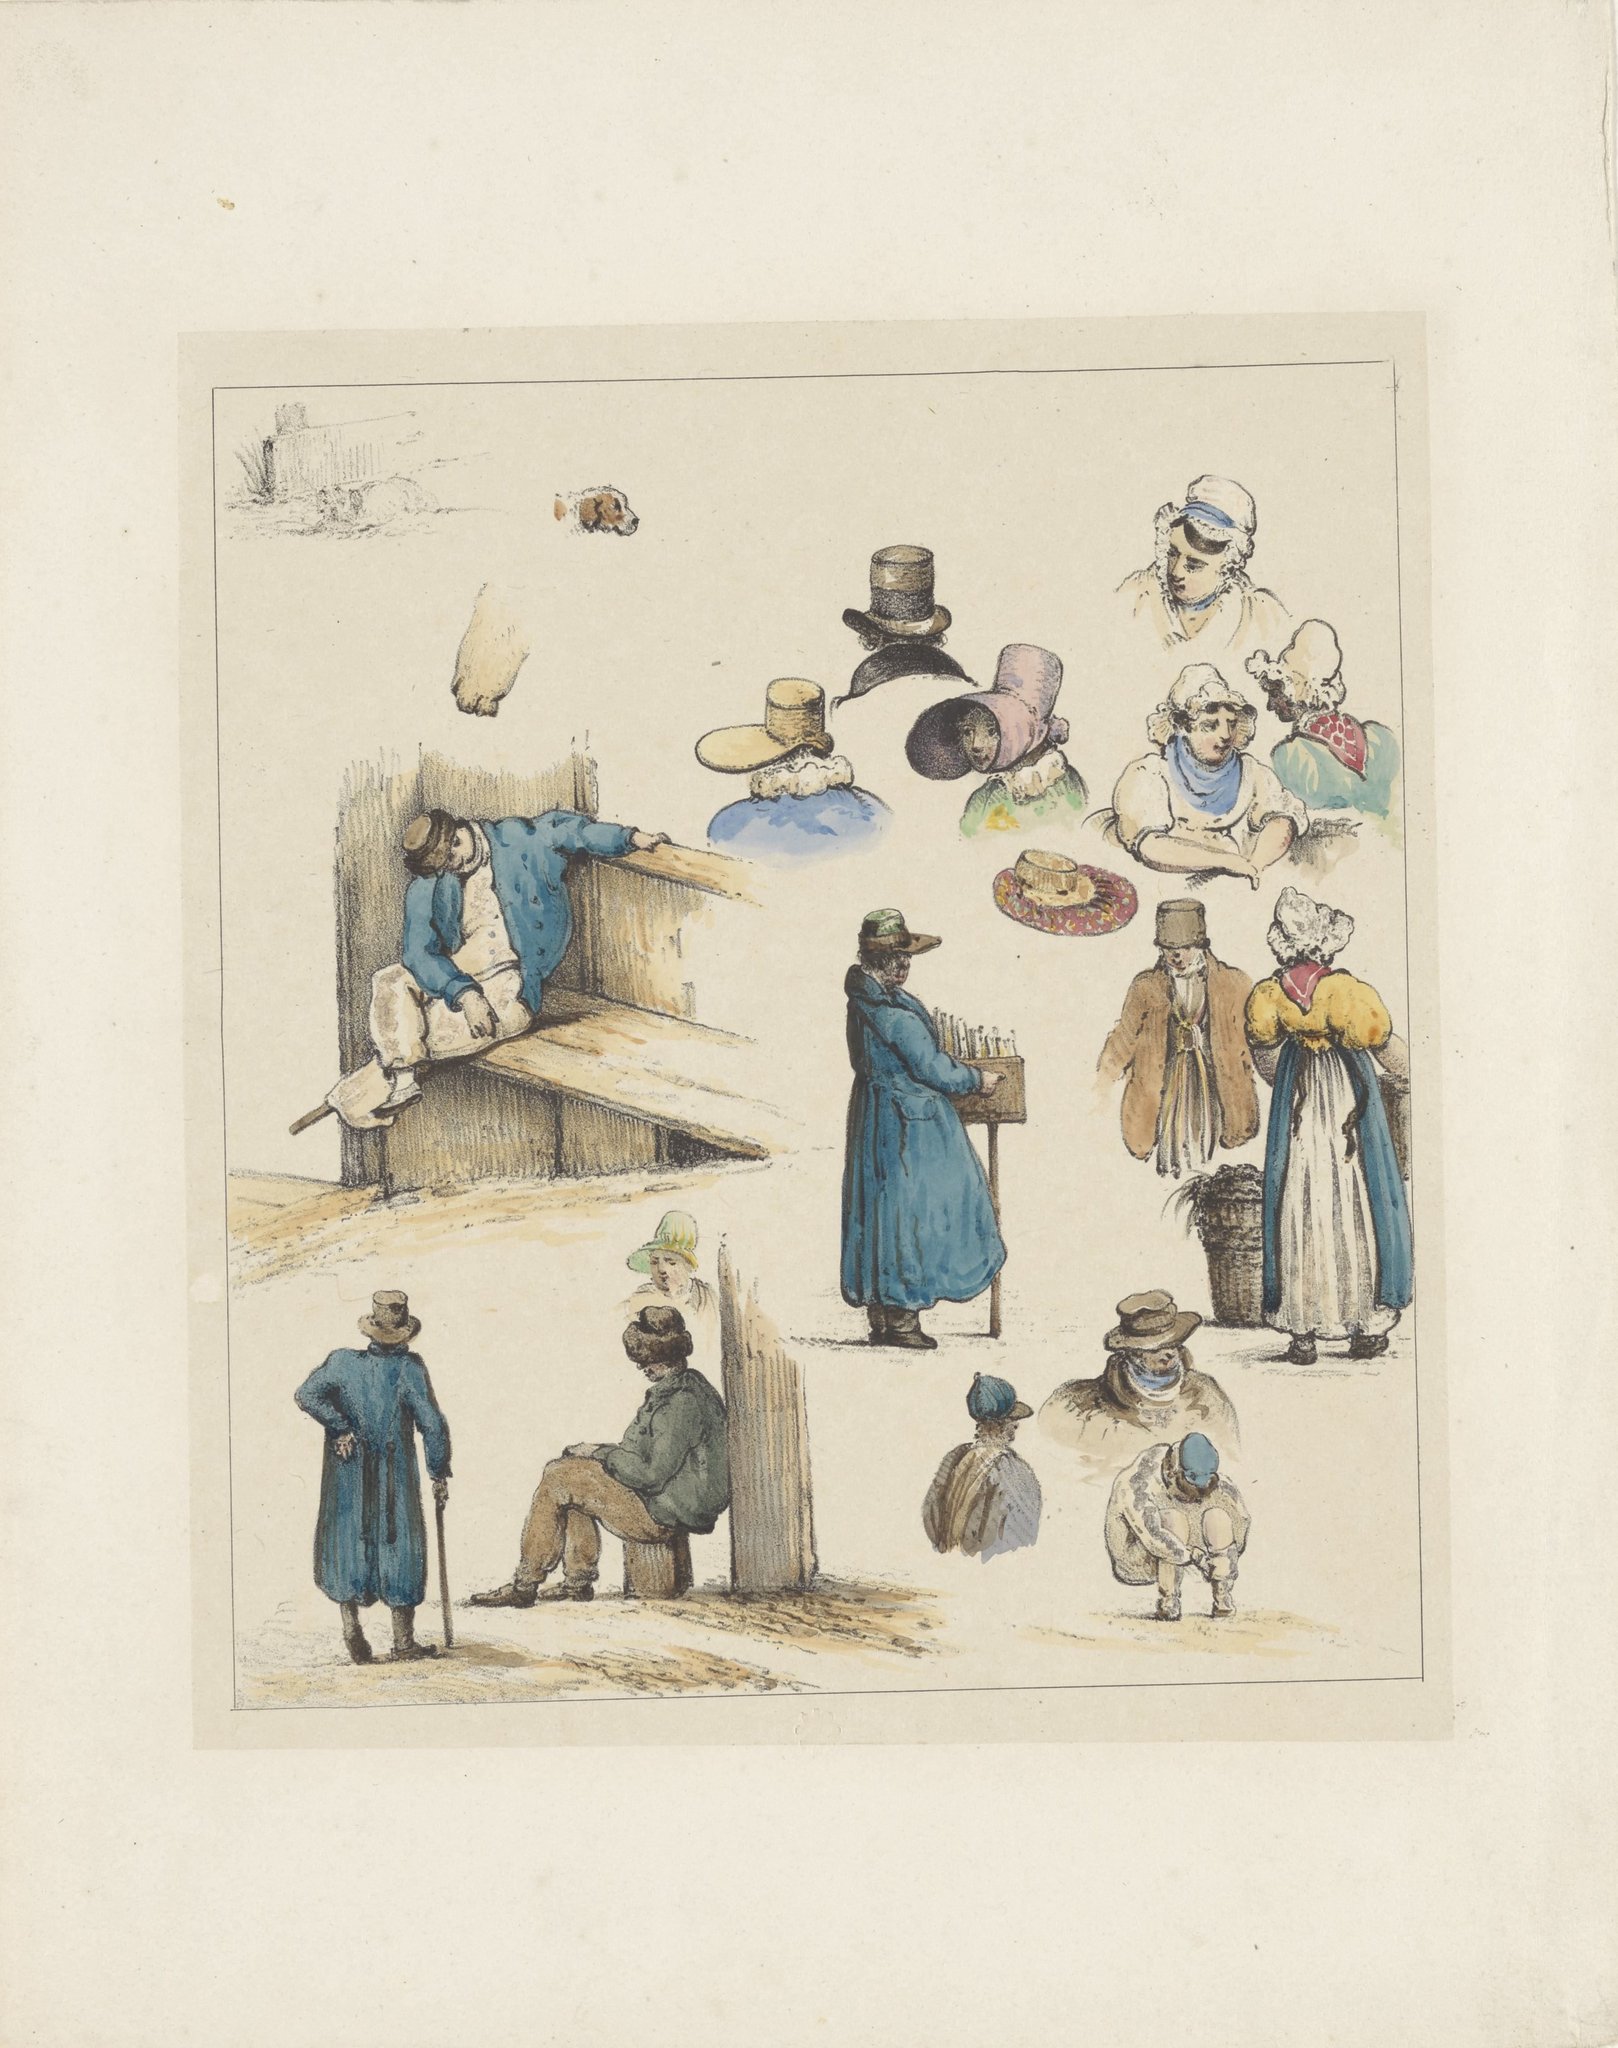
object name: print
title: Figuurstudies (eerste blad), 1833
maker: christiaan andriessen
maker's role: draughtsman, print maker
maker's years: 1775-1846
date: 1833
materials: paper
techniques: hand coloring, lithograph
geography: netherlands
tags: organ, street-trader, head-gear: cap, folk costume, regional costume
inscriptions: collector's mark: Lugt 2228, collector's mark:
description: Blad met figuren: links een man slapend op een houten bank en een man met een draaiorgel. Onderdeel van een serie van zes bladen met figuurstudies van Nederlandse klederdrachten, straatfiguren en gebuiken, 1833.